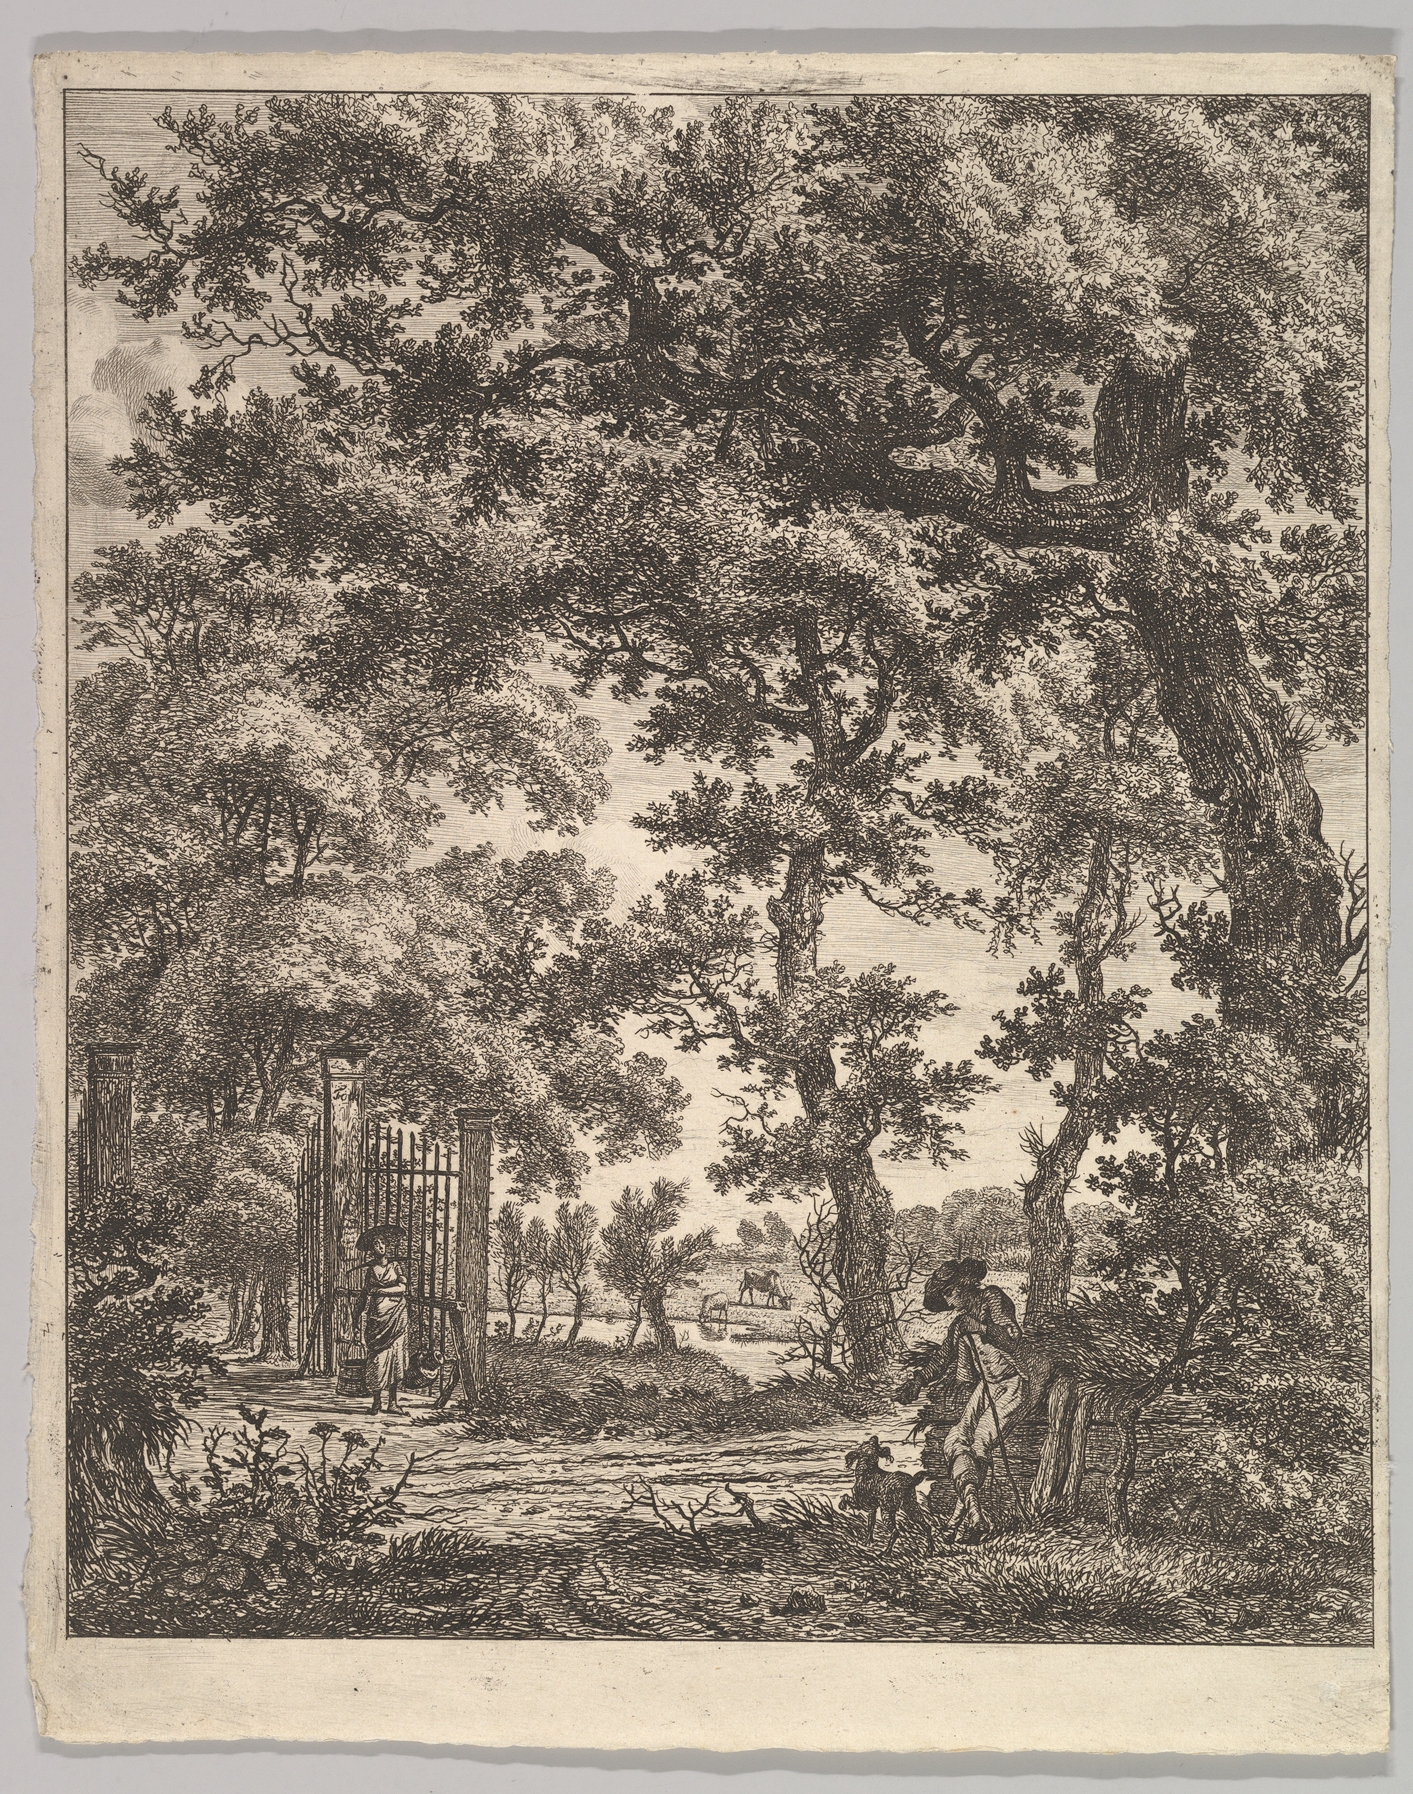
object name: print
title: Landscape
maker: hermanus fock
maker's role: artist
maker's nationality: dutch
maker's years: 1766-1822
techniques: etching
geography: germany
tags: human figures,dogs,landscapes,trees